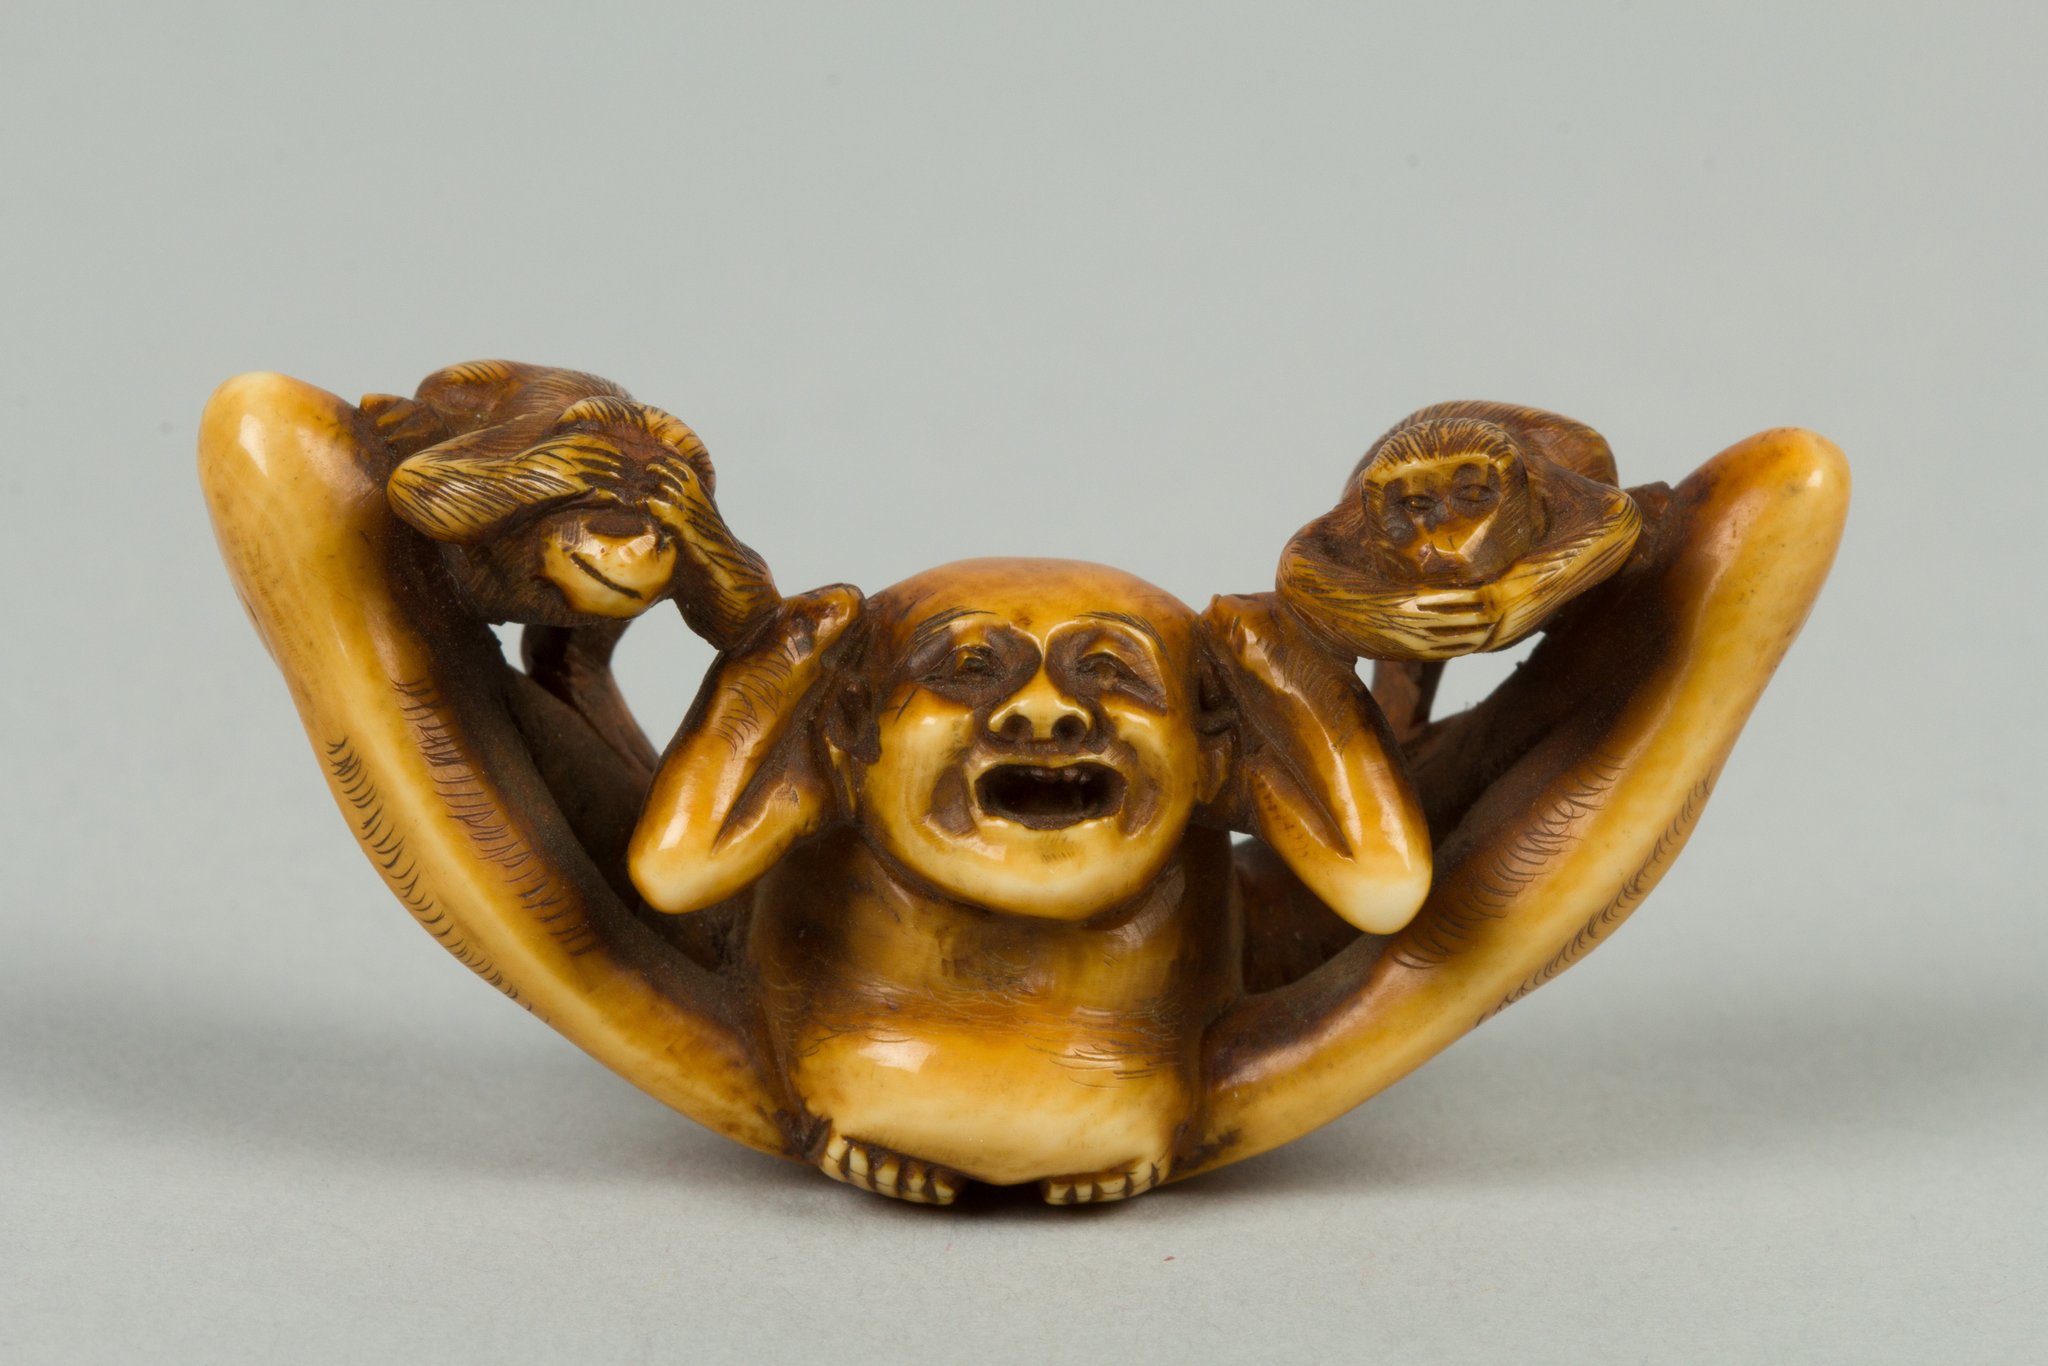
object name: netsuke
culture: japanese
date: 1801-1900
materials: ivory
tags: men,monkeys